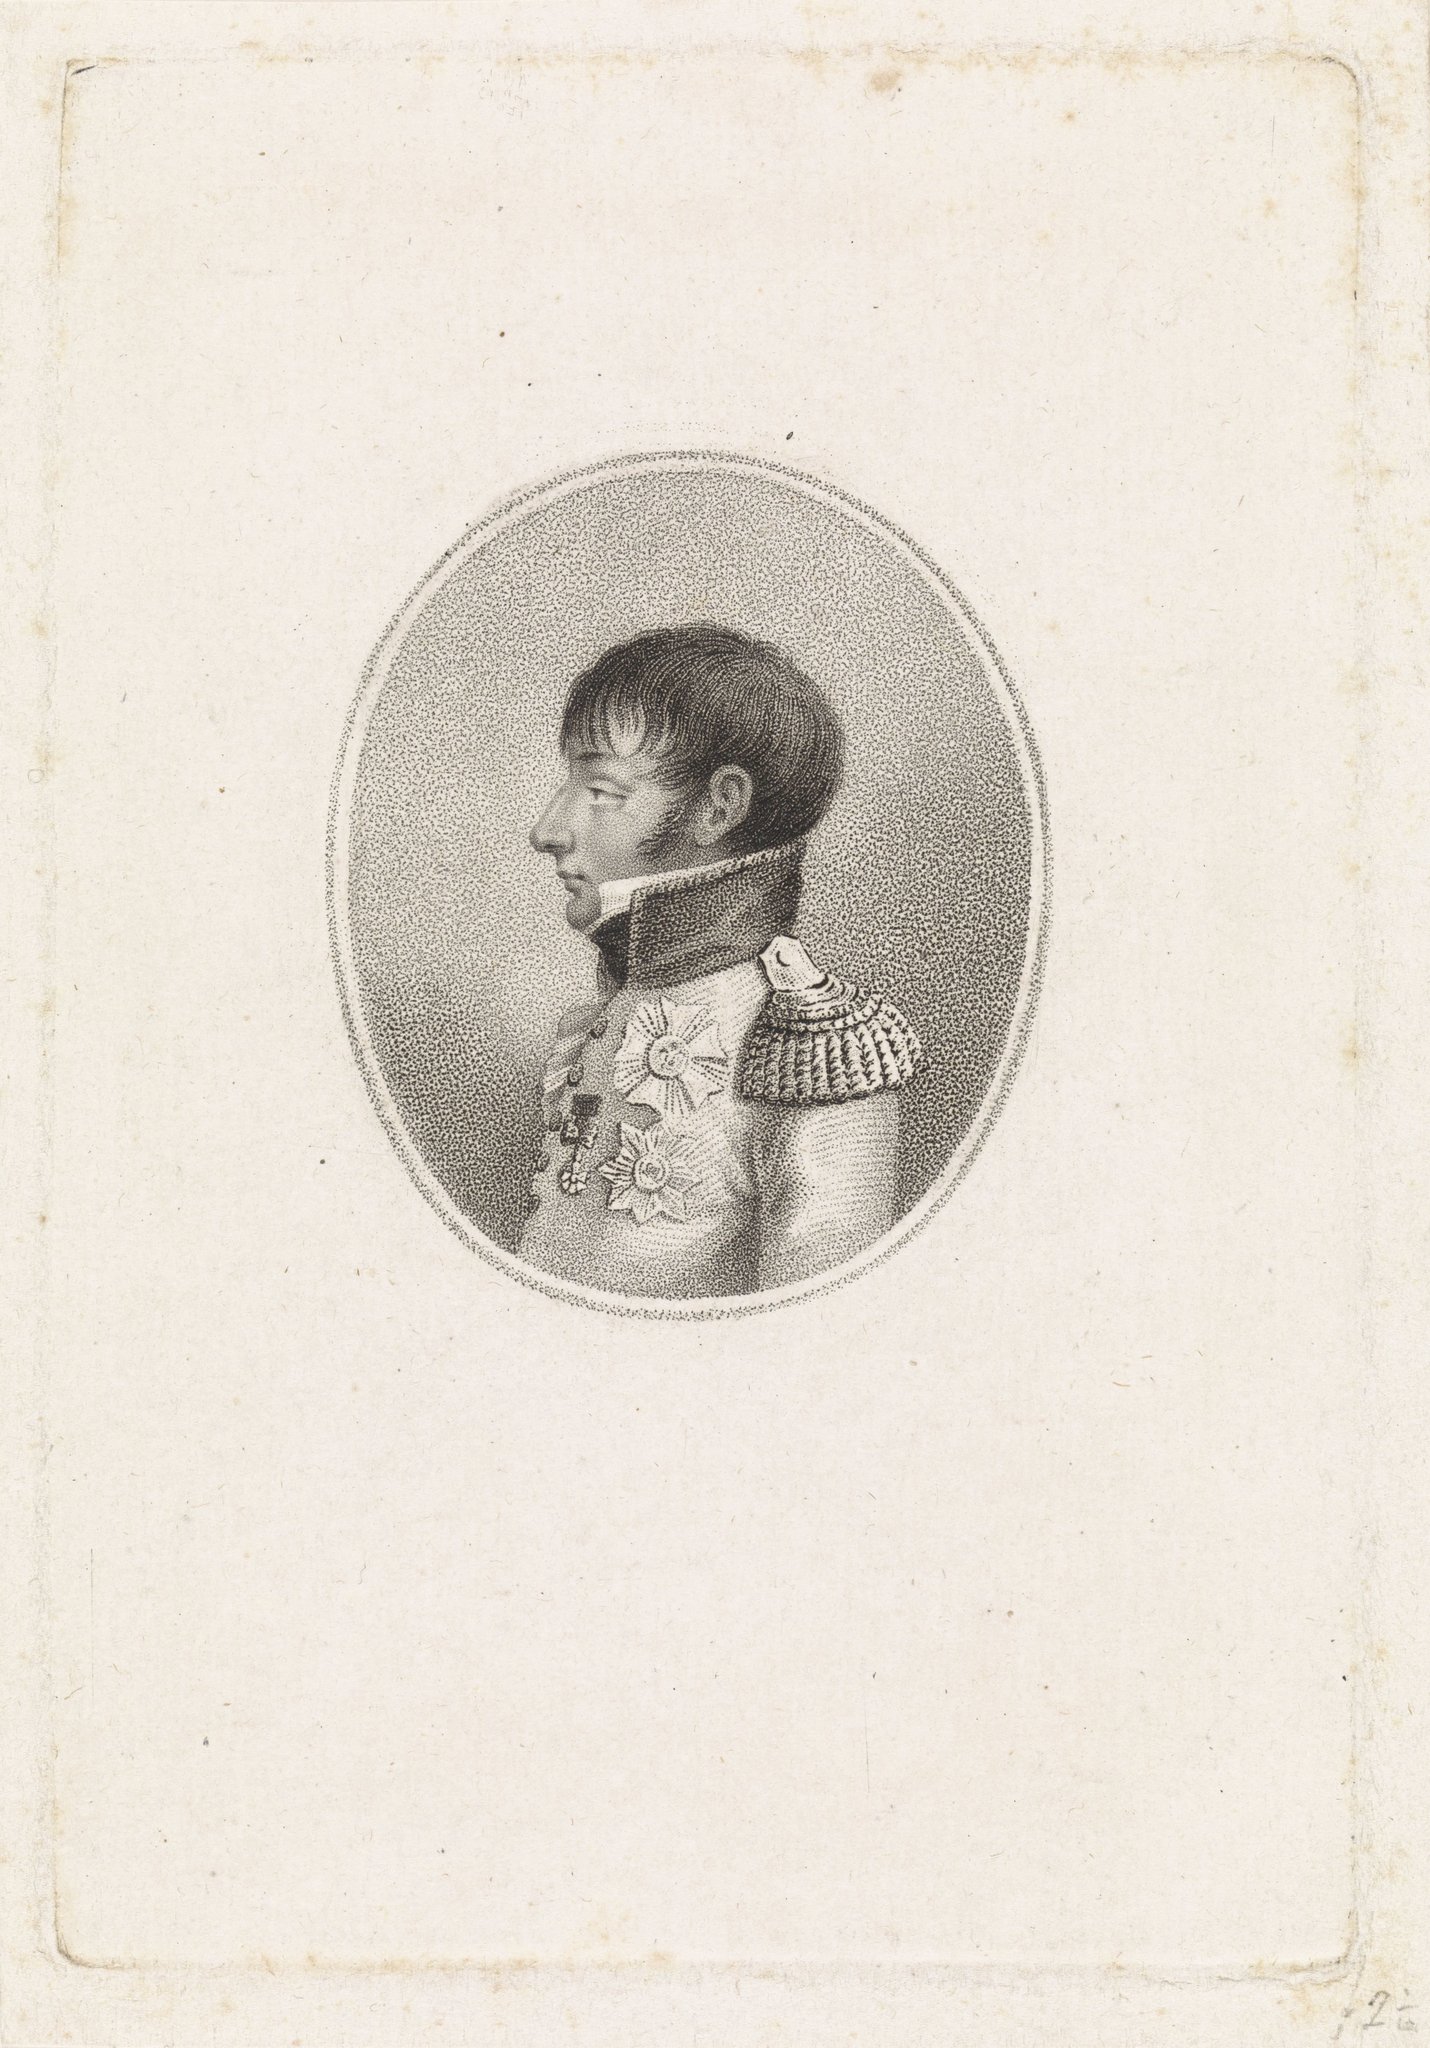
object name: print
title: Portret van Lodewijk Napoleon Bonaparte, koning van Holland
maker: ludwig gottlieb portman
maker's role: print maker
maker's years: 1772-1828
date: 1809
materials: paper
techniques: stippled etching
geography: amsterdam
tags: louis napoleon (king of holland), knighthood order, holland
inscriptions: collector's mark: Lugt 2228